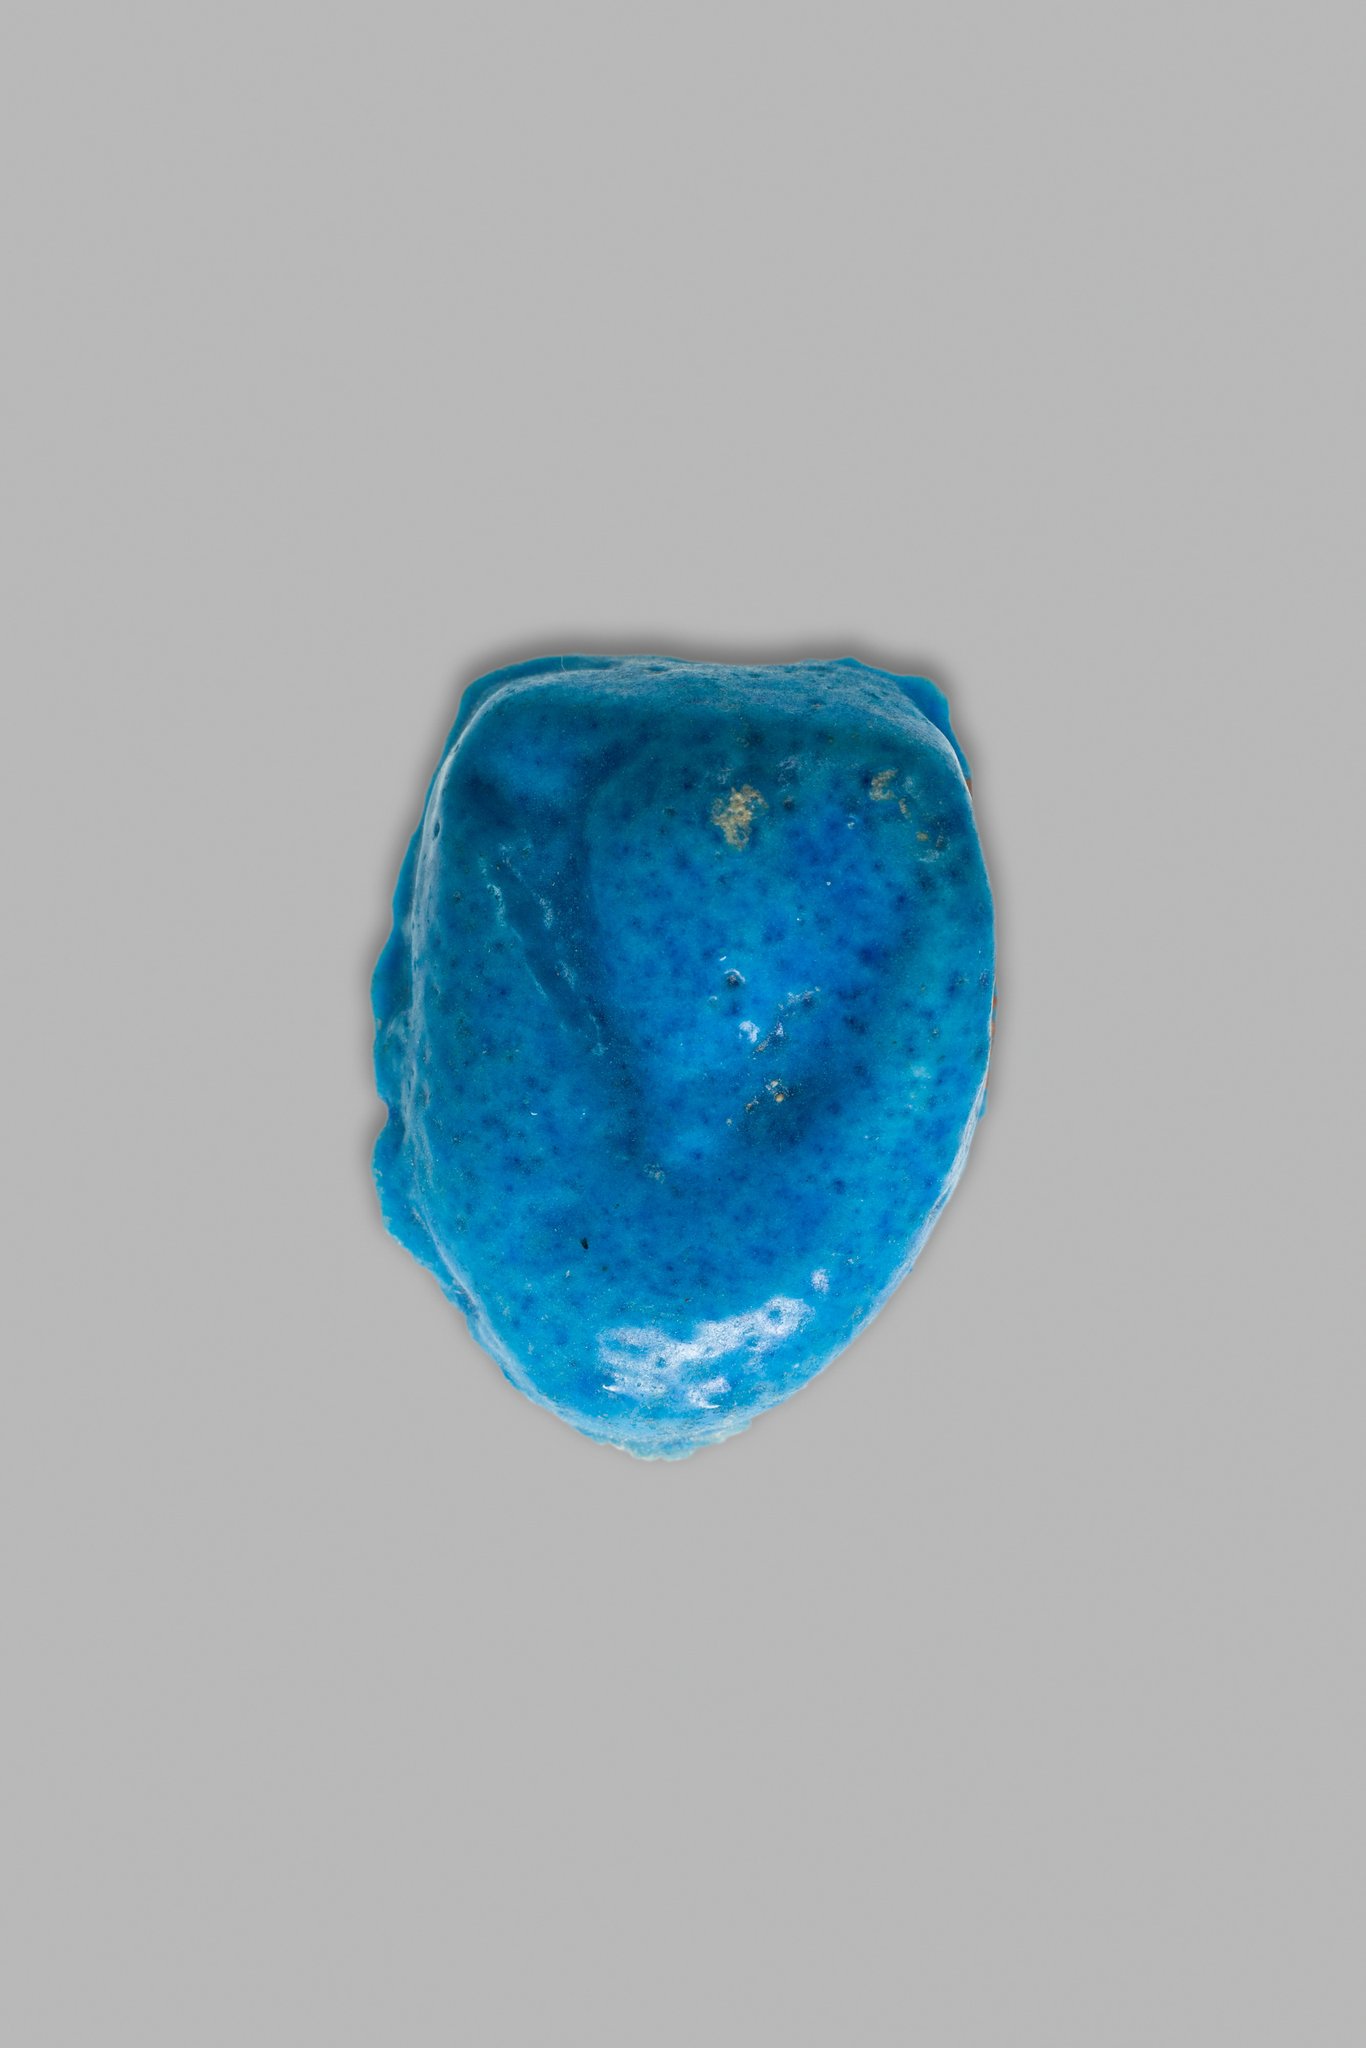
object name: foundation deposit, plaque, lotus, lily, ramesses iv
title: Lotus-Shaped Plaque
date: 1153-1147 BCE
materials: faience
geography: egypt